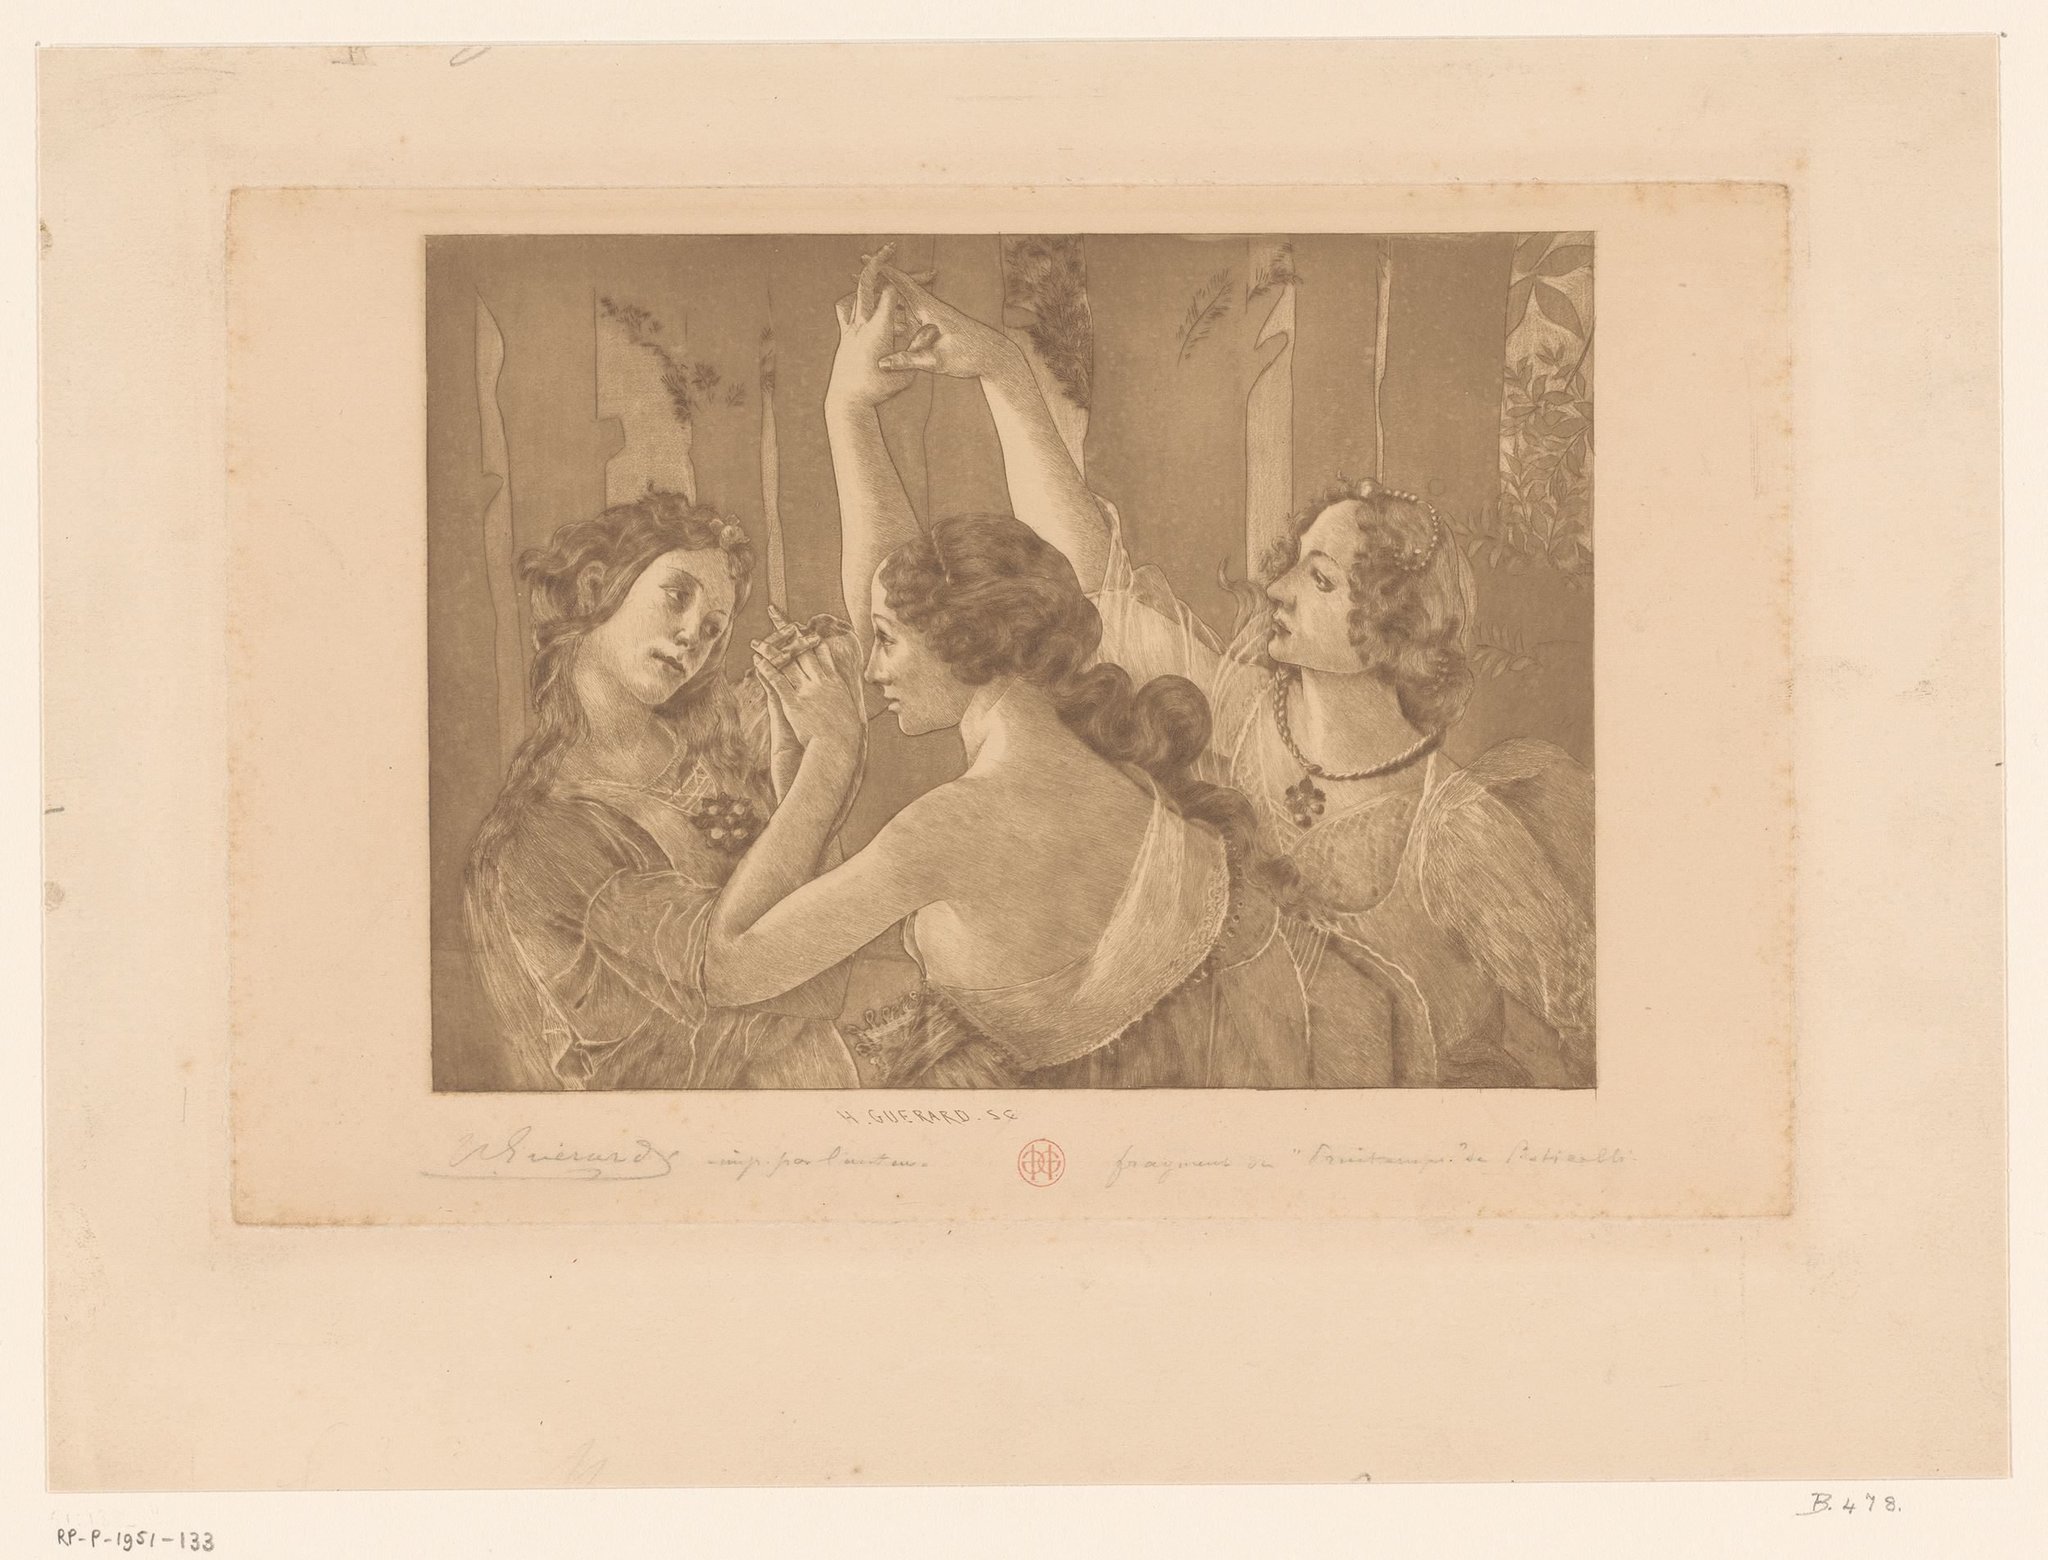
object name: print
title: Drie gratiën van de Primavera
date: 1886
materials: paper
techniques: aquatint, etching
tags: spring, 'ver'; 'primavera' (ripa), graces (charites), generally three in number; 'gratie' (ripa)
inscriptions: stamp: Lugt 1157, annotation: ‘imp. par l'auteur. Fragment du "Primtemps" de Boticelli.’, collector's mark: Lugt 2228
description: Gepubliceerd in 'Gazette des Beaux-Arts', 1886, p. 475.